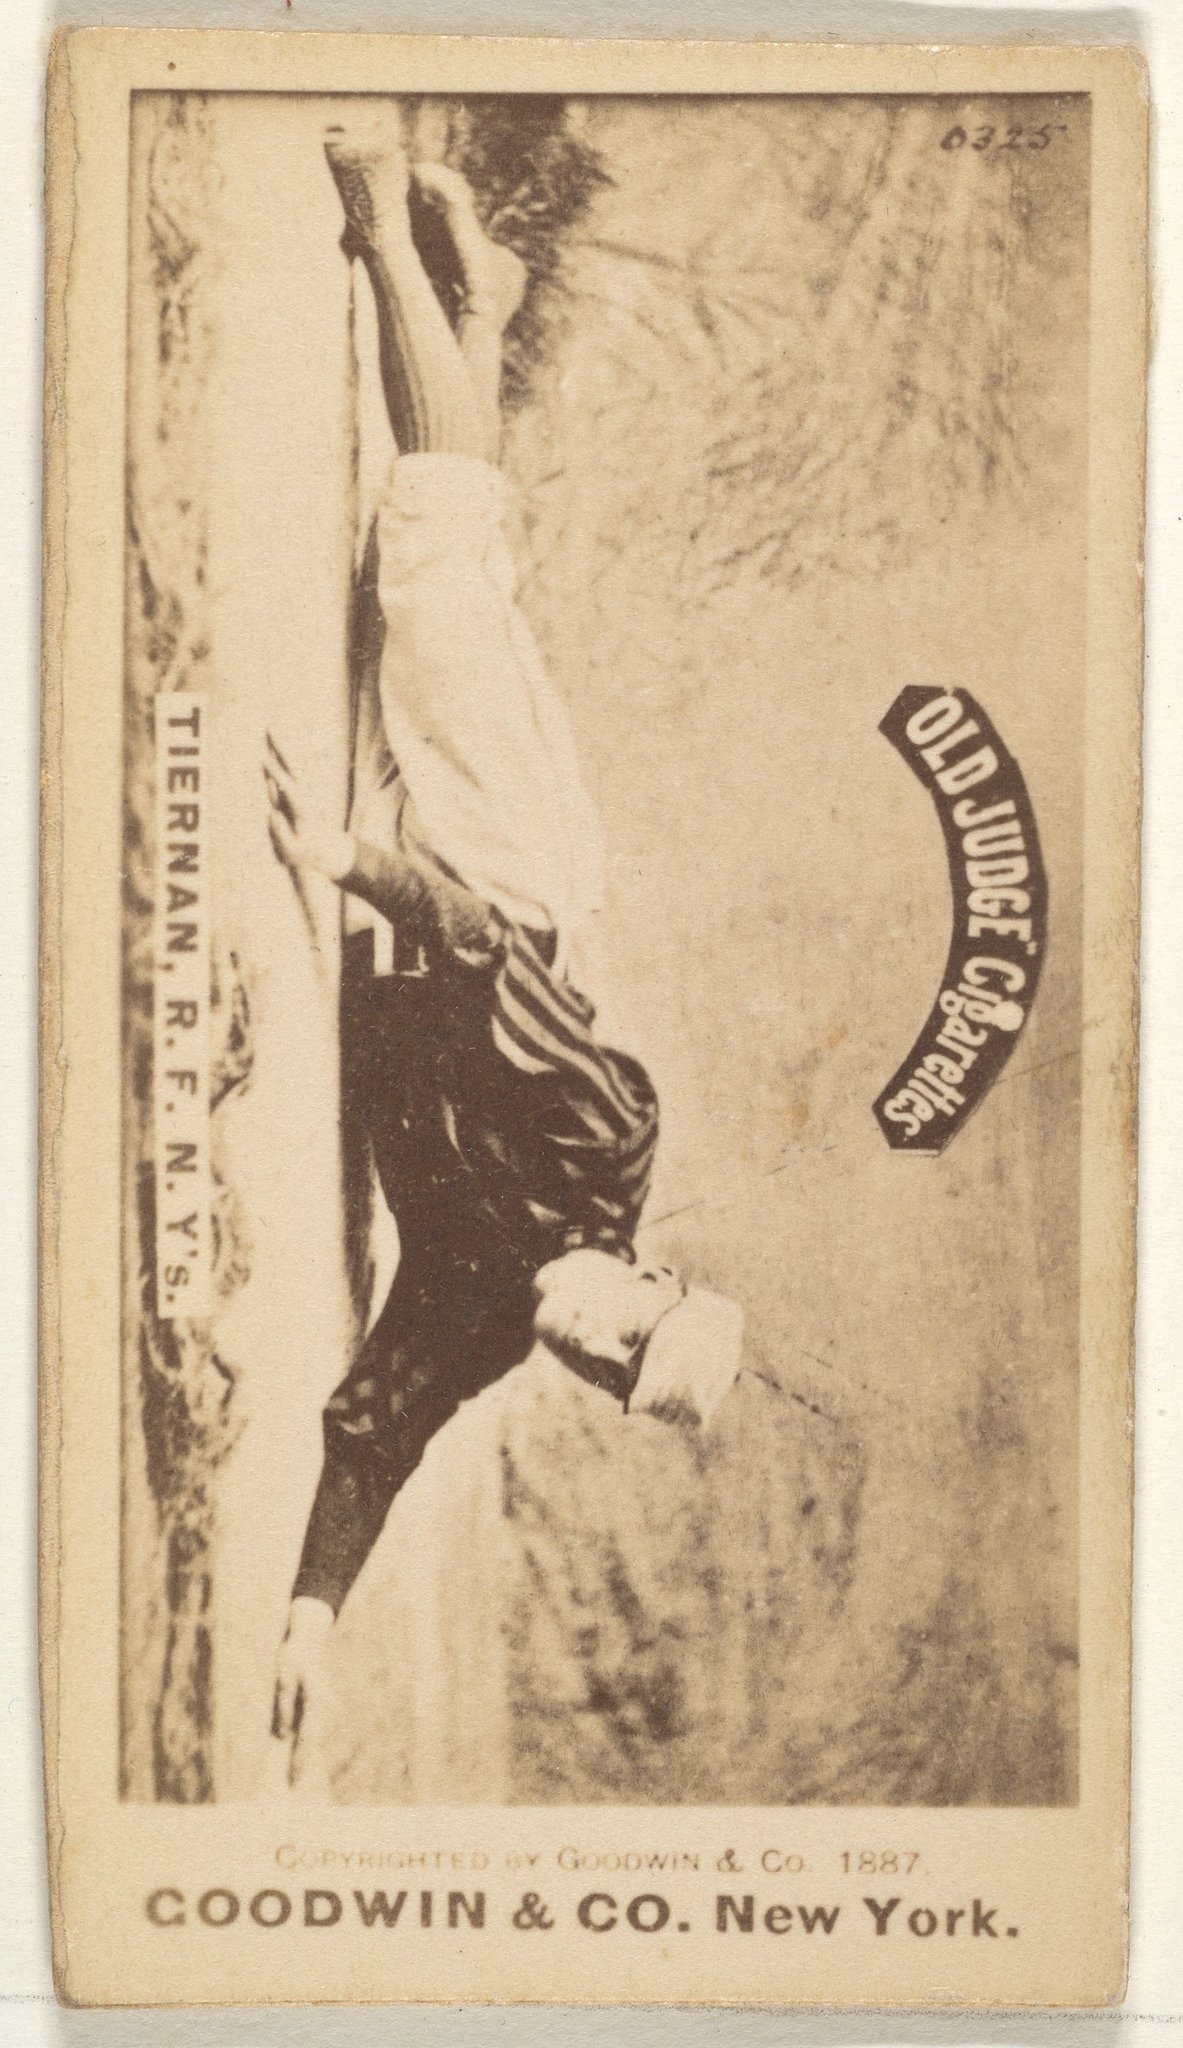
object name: baseball card, photograph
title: Michael "Silent Mike" Joseph Tiernan, Right Field, New York, from the Old Judge series (N172) for Old Judge Cigarettes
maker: goodwin & company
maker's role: publisher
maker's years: 1850-1950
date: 1887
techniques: albumen silver print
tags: men,portraits,baseball,athletes